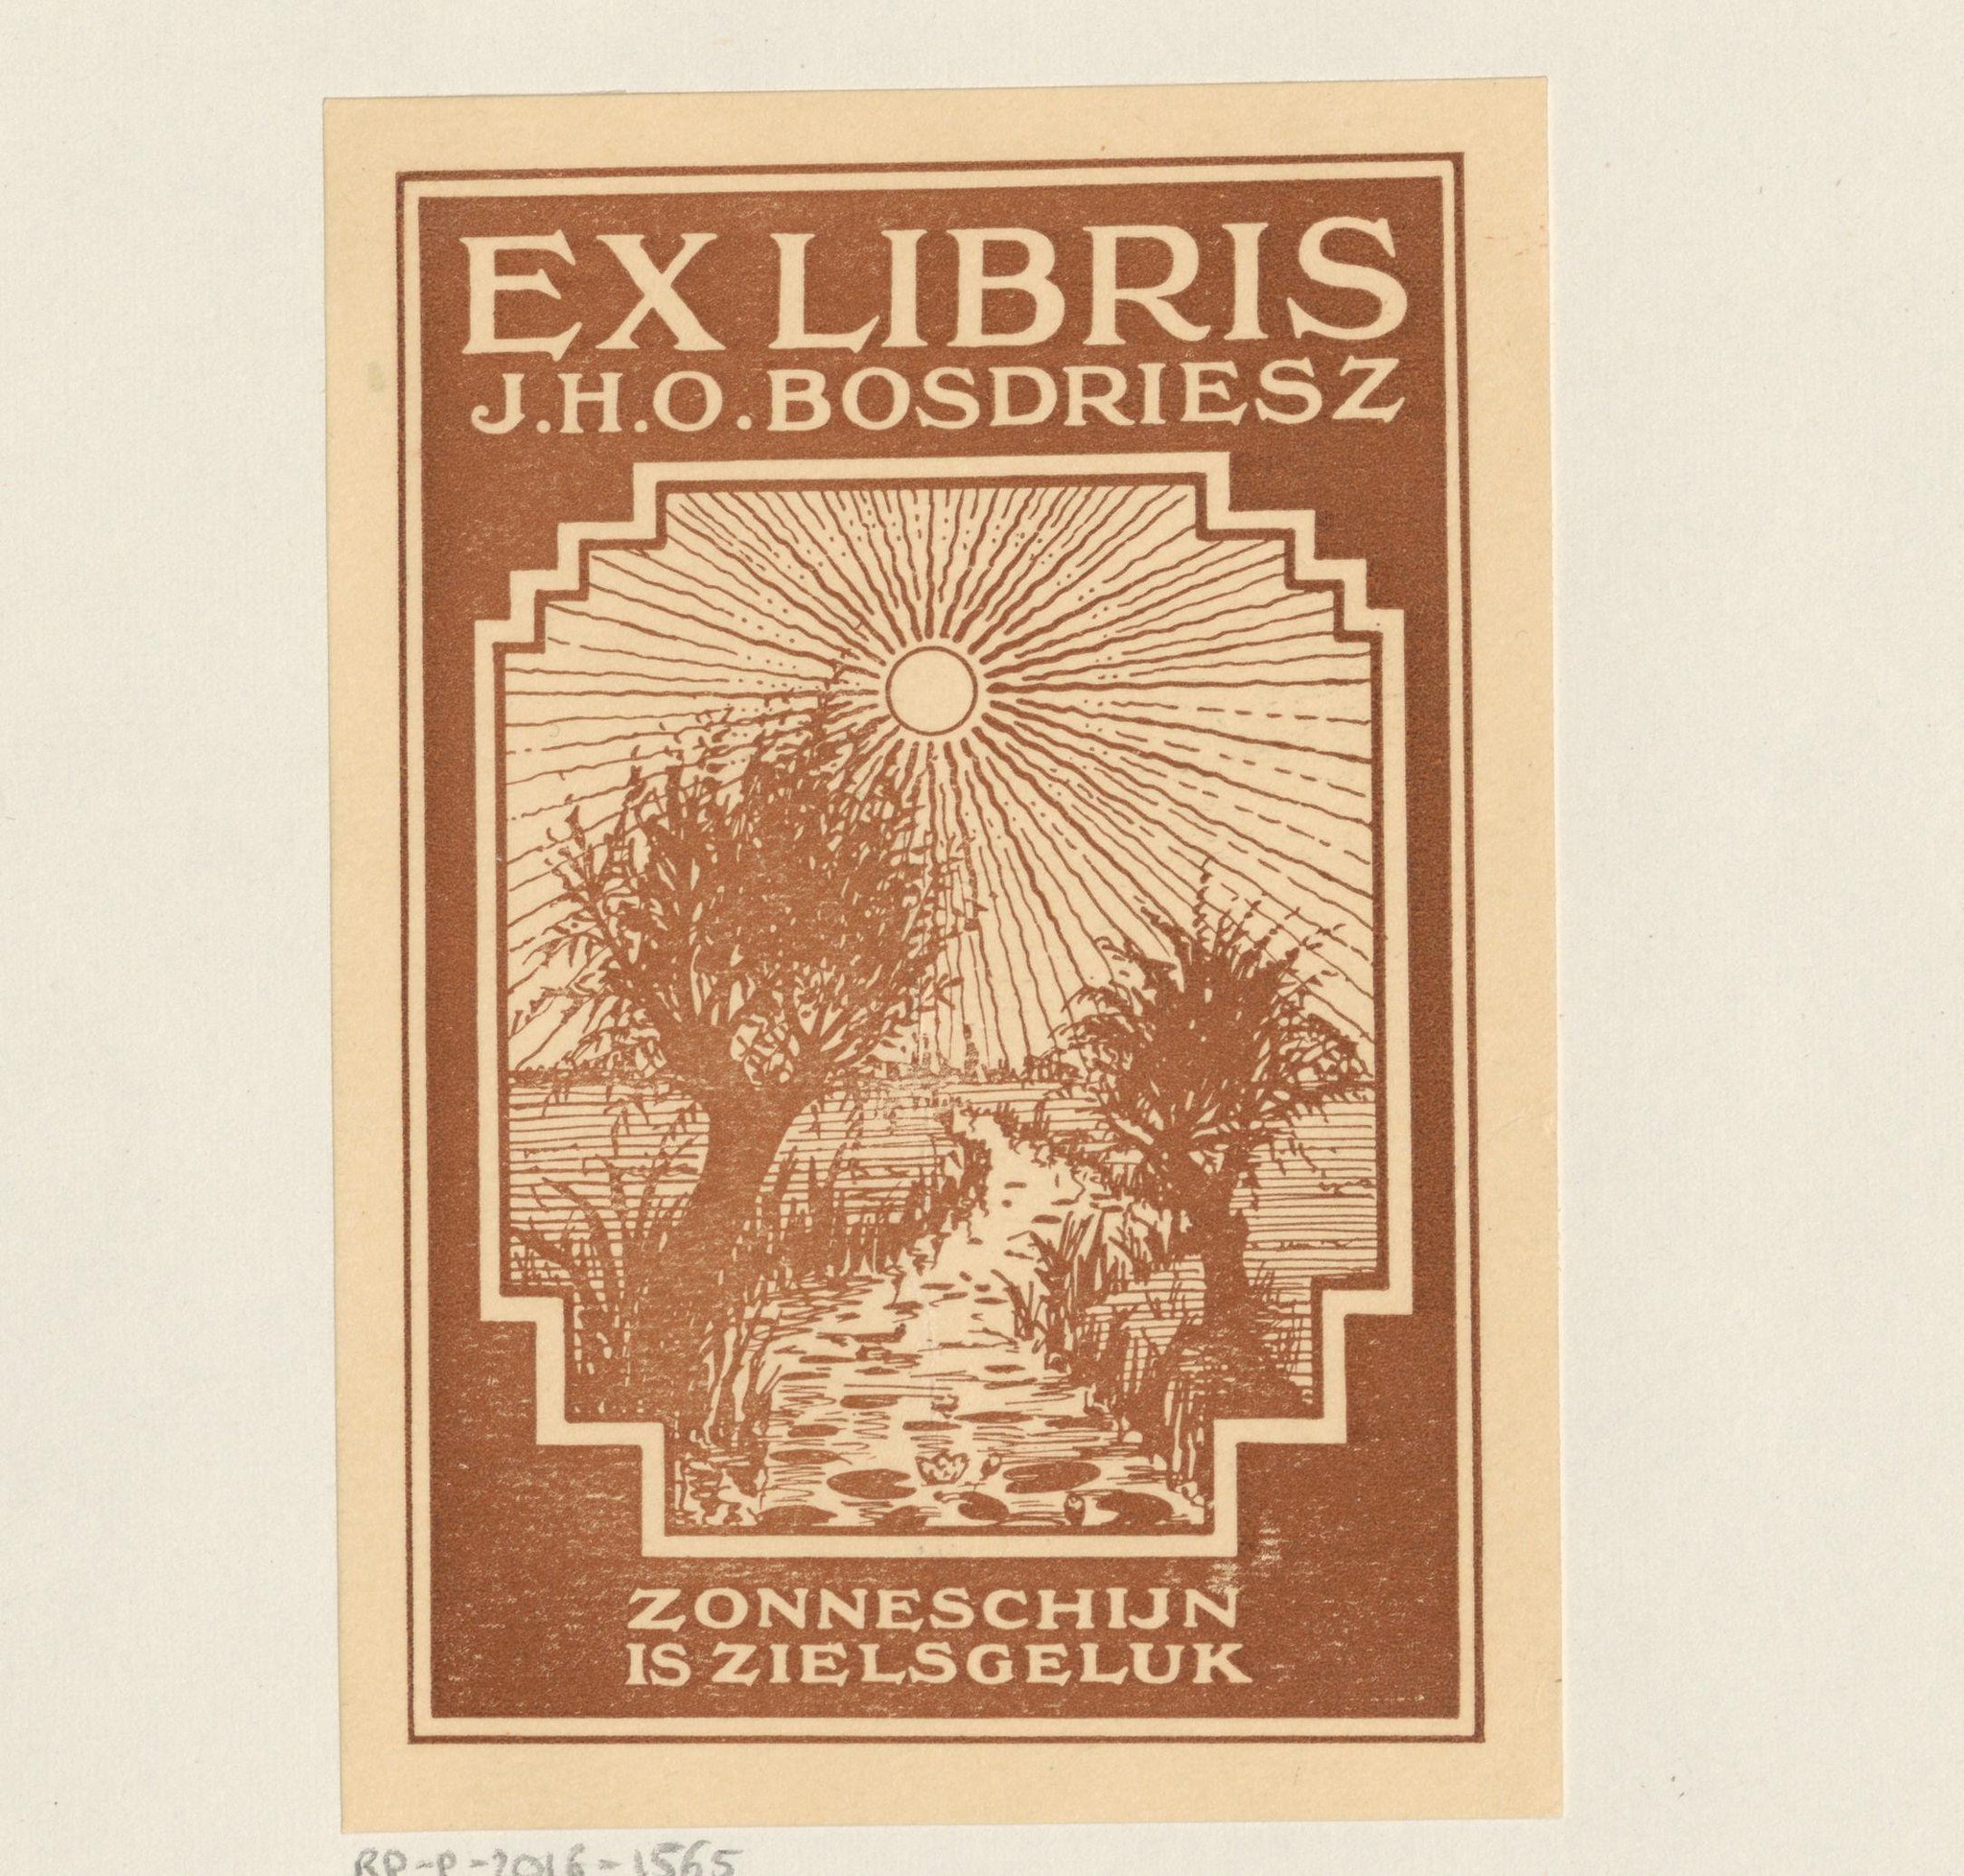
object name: bookplate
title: Ex libris van J.H.O. Bosdriesz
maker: jan hendrik olivier bosdriesz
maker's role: printer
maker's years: 1901-1945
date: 1911-1944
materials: paper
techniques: printing block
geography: netherlands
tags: printer, jan hendrik olivier bosdriesz, meadow, pasture, trees: willow